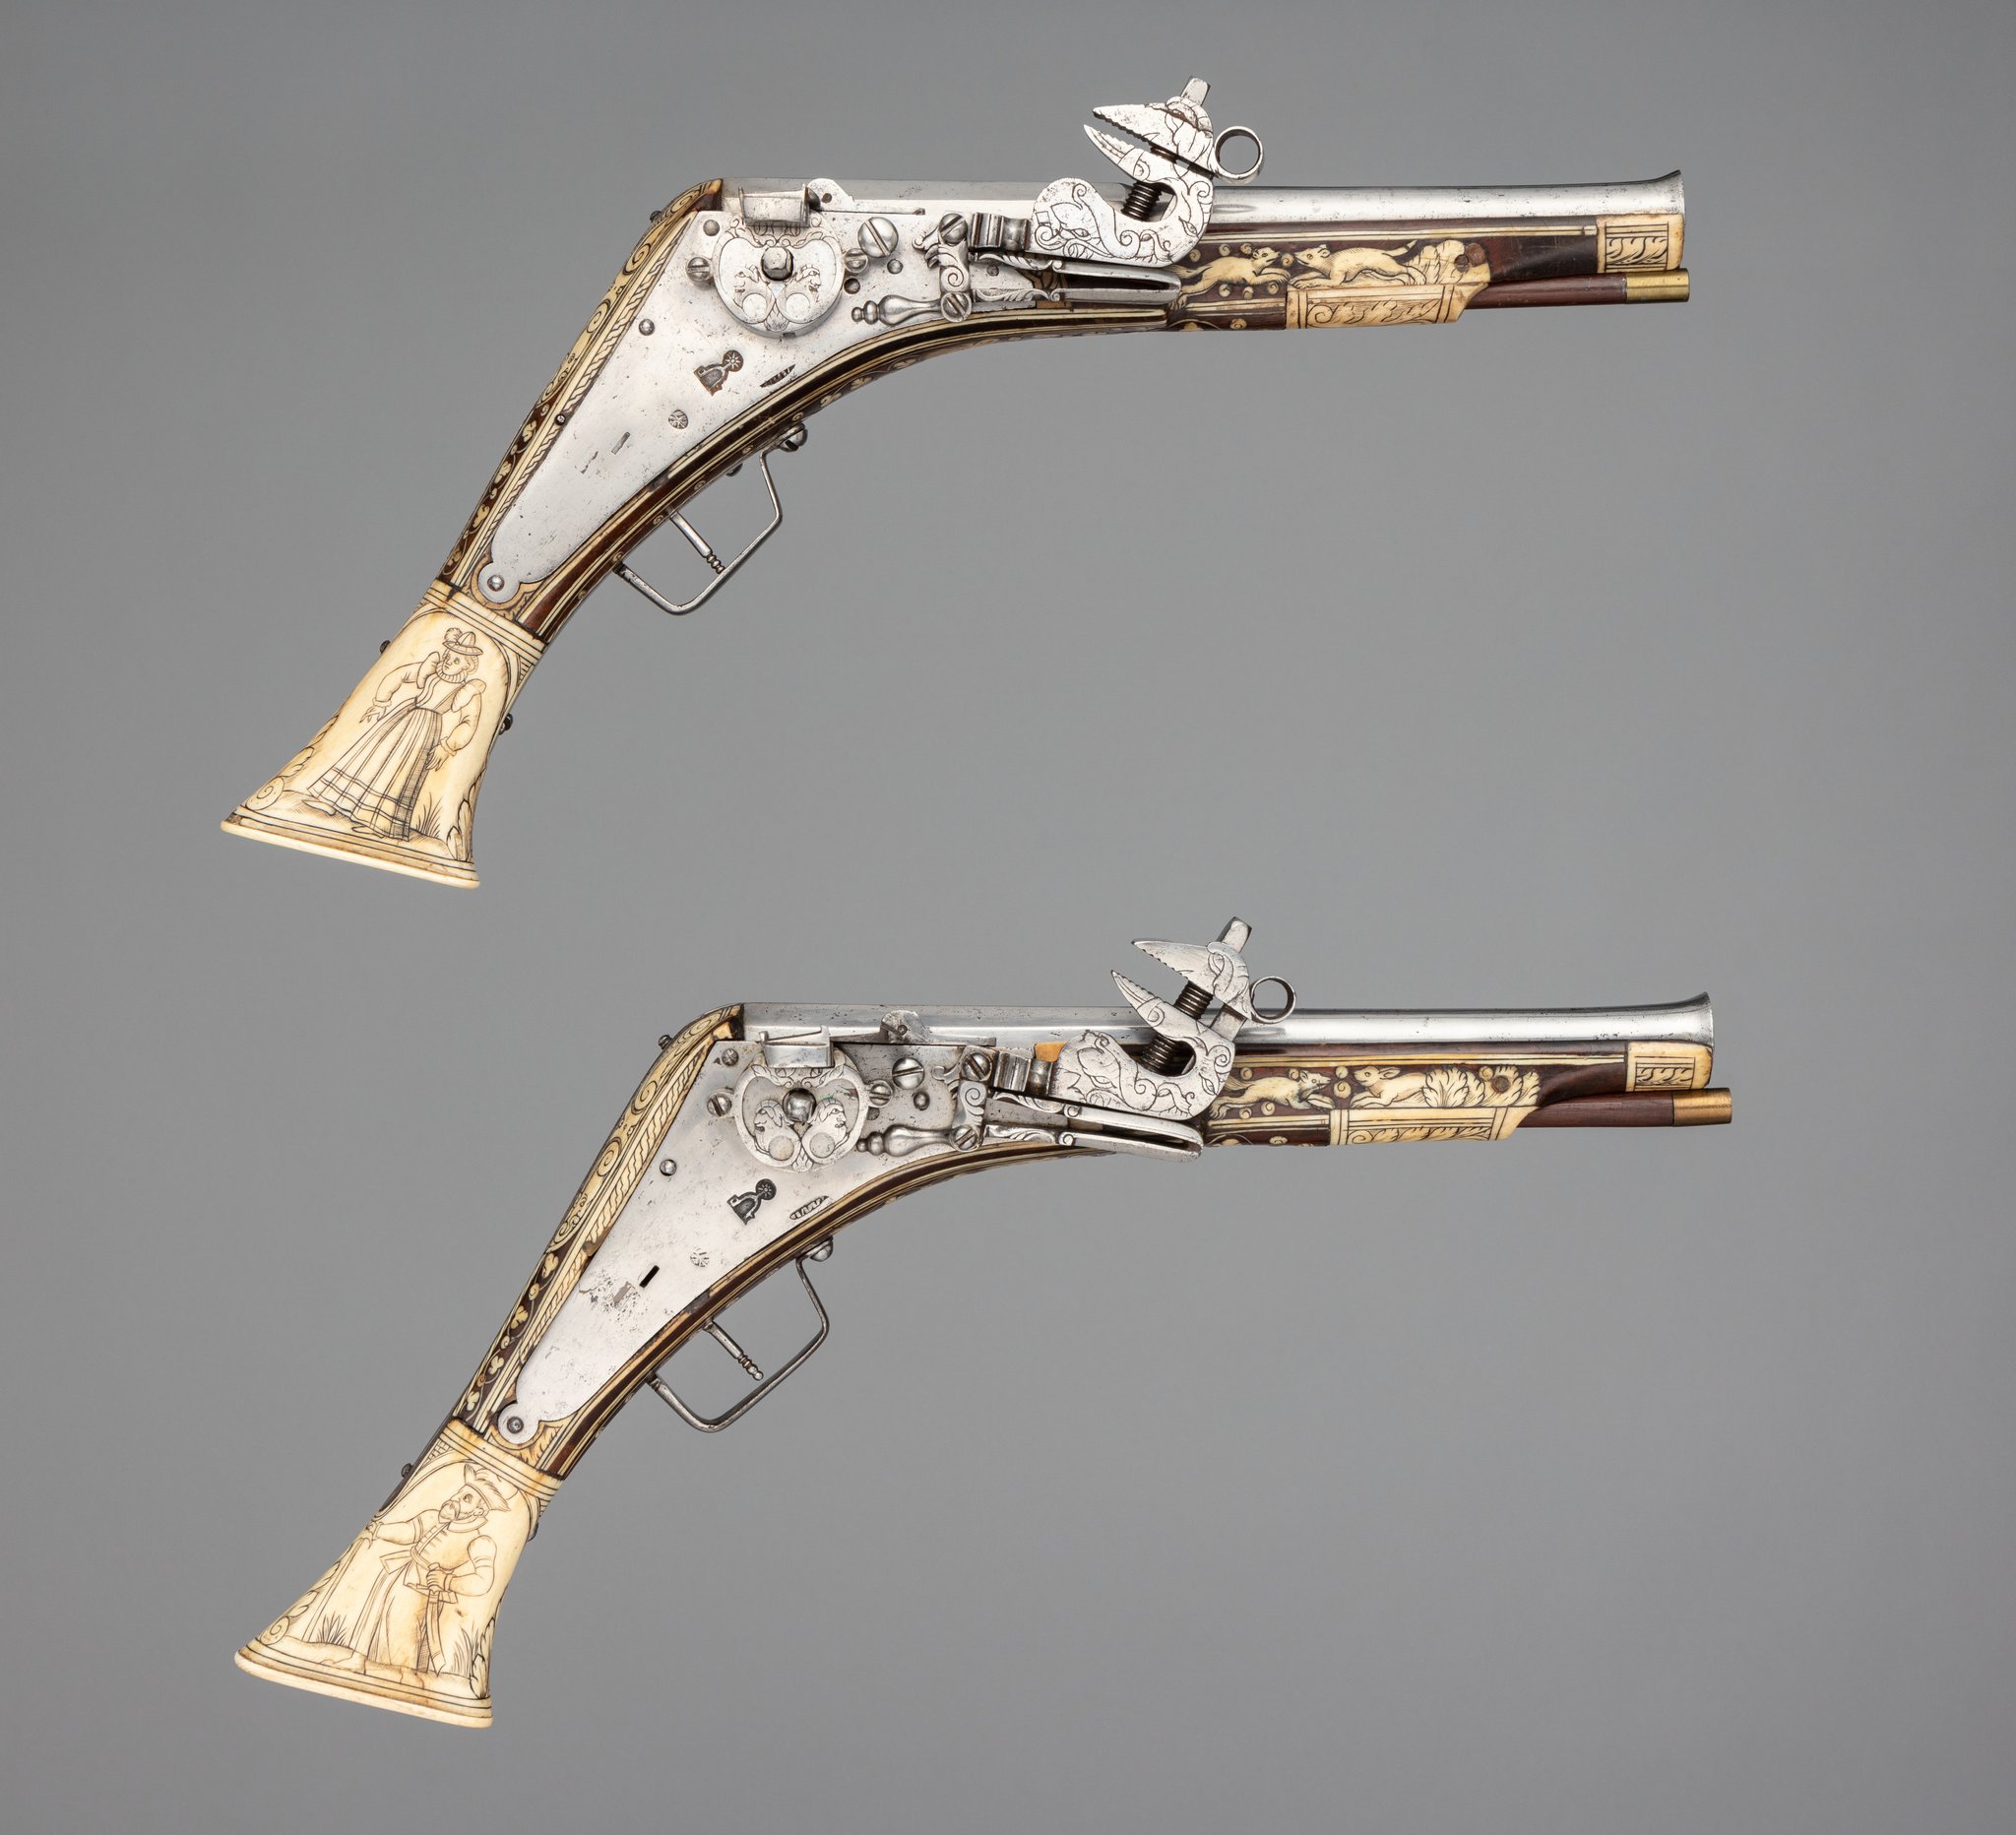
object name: pair of wheellock pistol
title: Pair of Wheellock Pistols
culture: german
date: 1590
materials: ivory, steel, wood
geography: germany